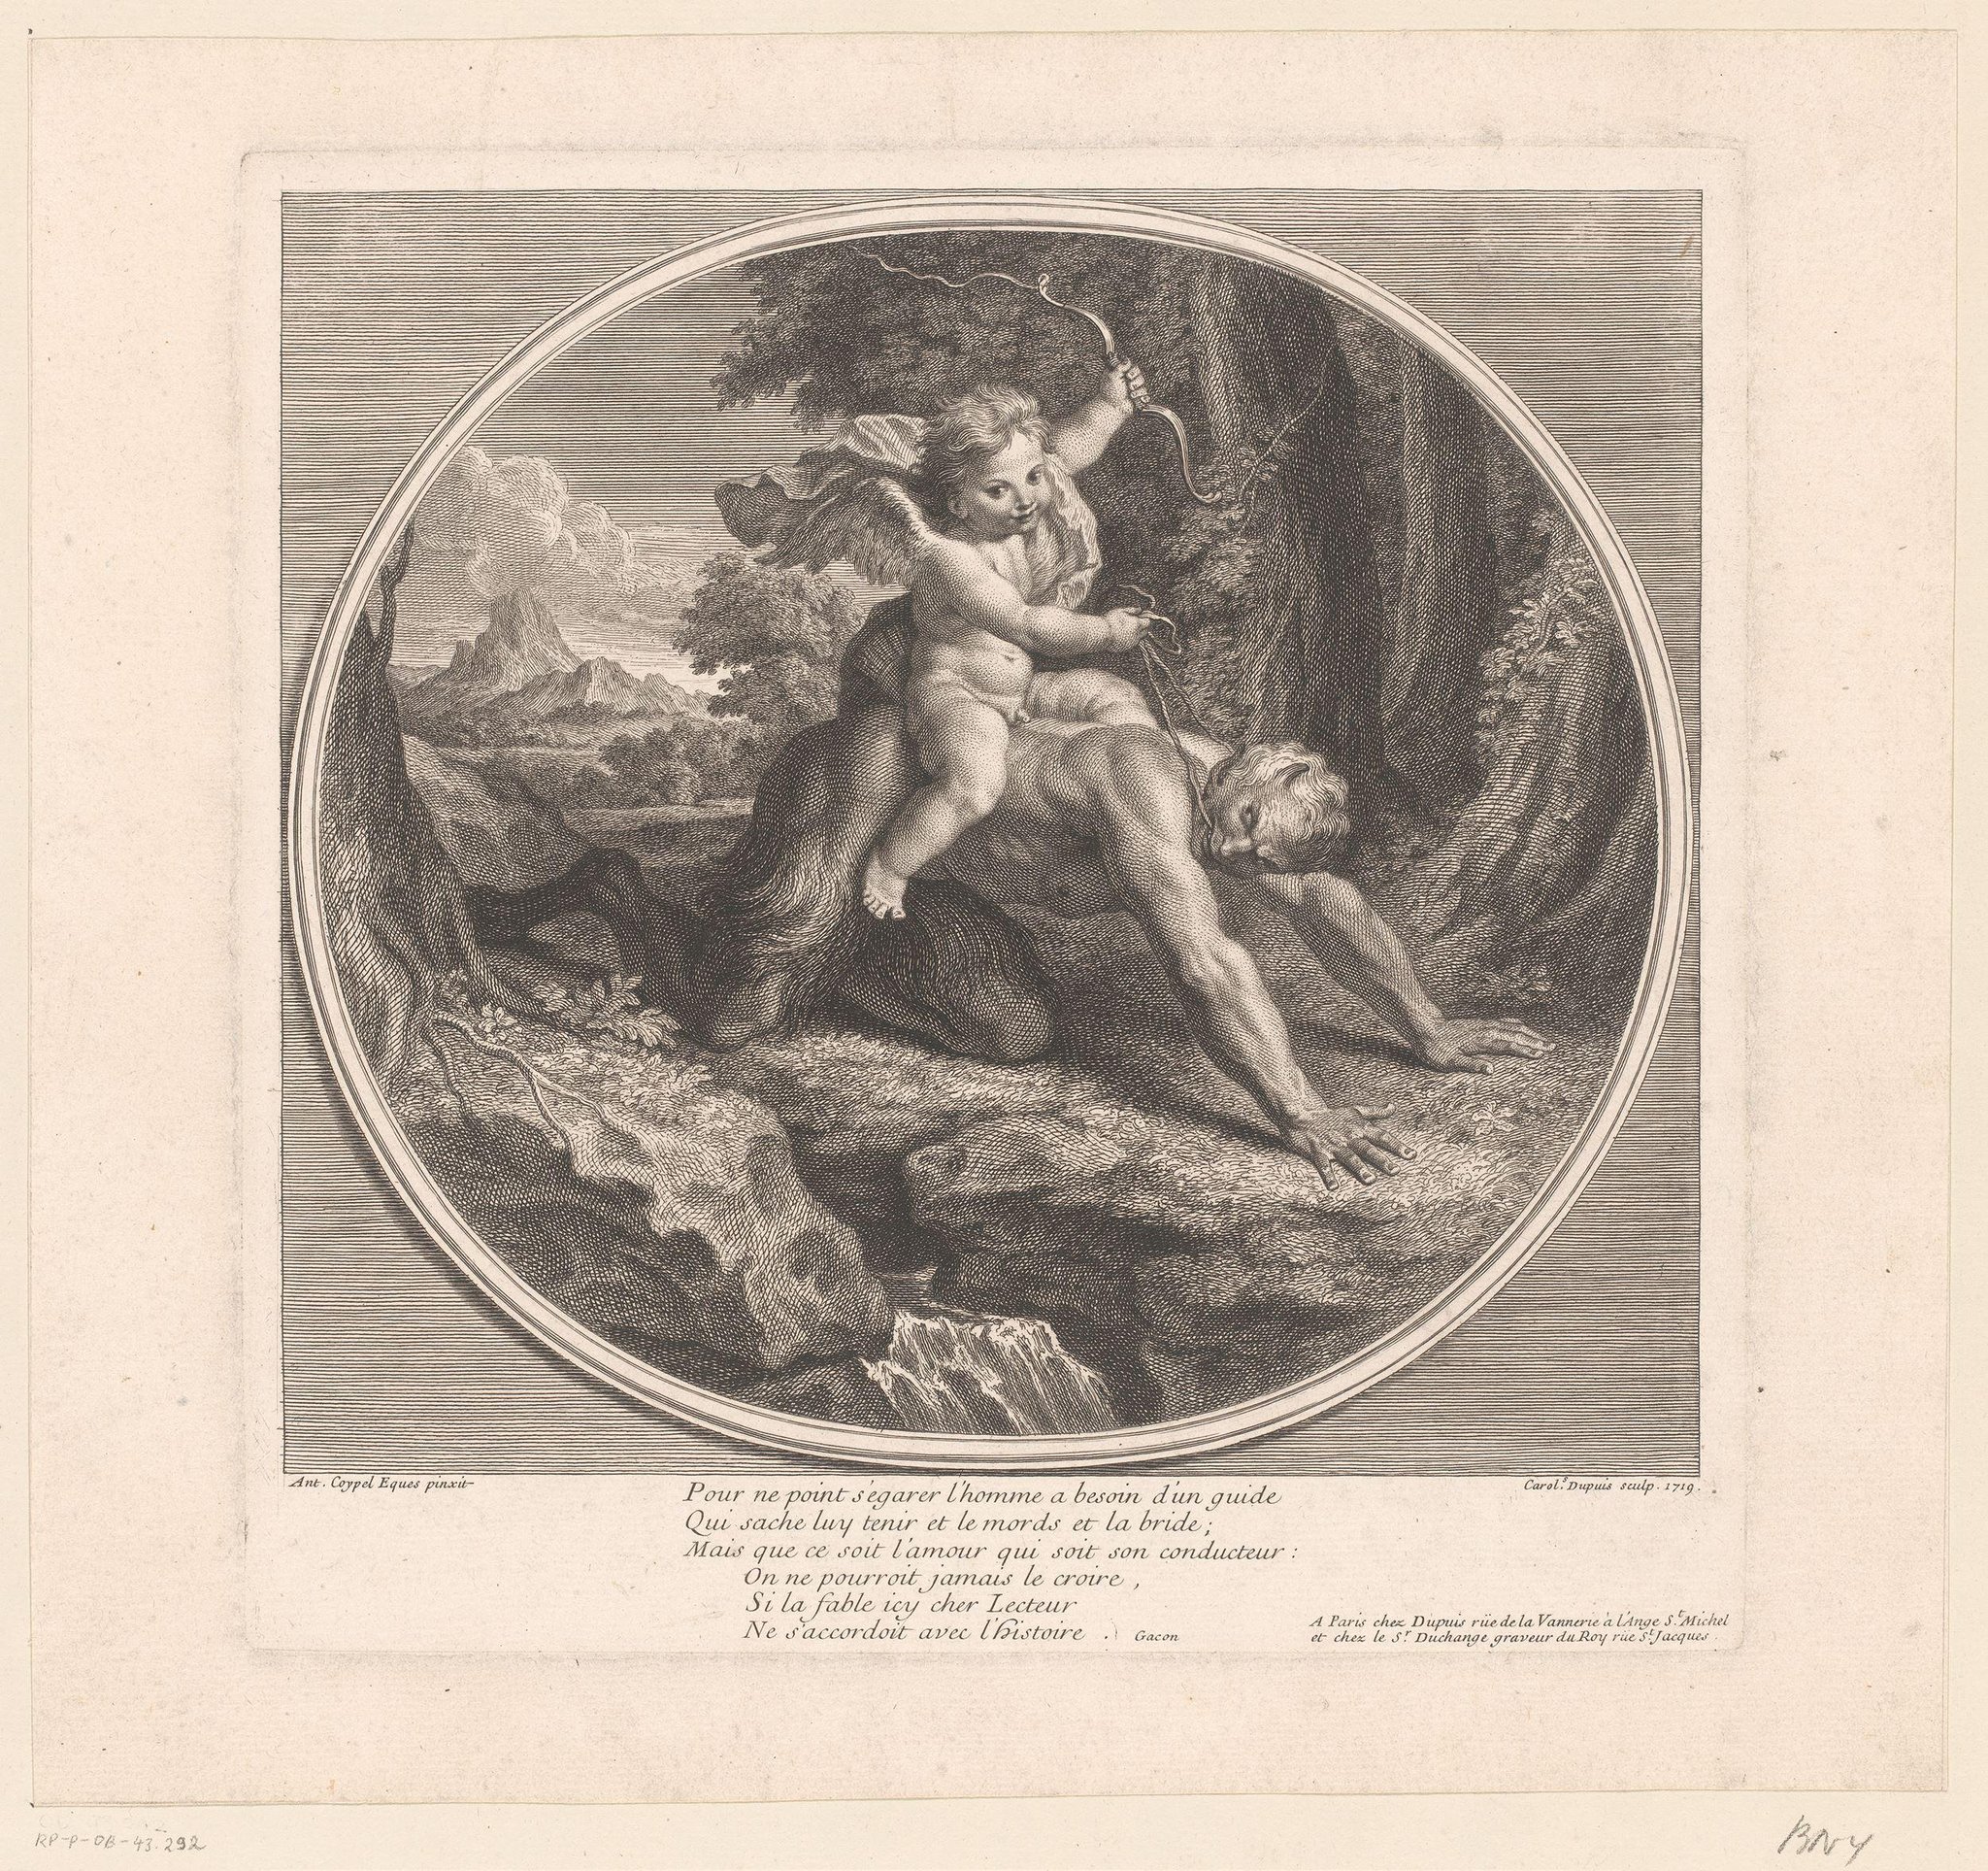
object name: print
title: Amor op een sater met teugels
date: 1719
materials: paper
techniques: engraving, etching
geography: france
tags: riding a horse, ass, or mule; rider, horseman, satyr(s) (in general), (story of) cupid, amor (eros)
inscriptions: collector's mark: Lugt 240